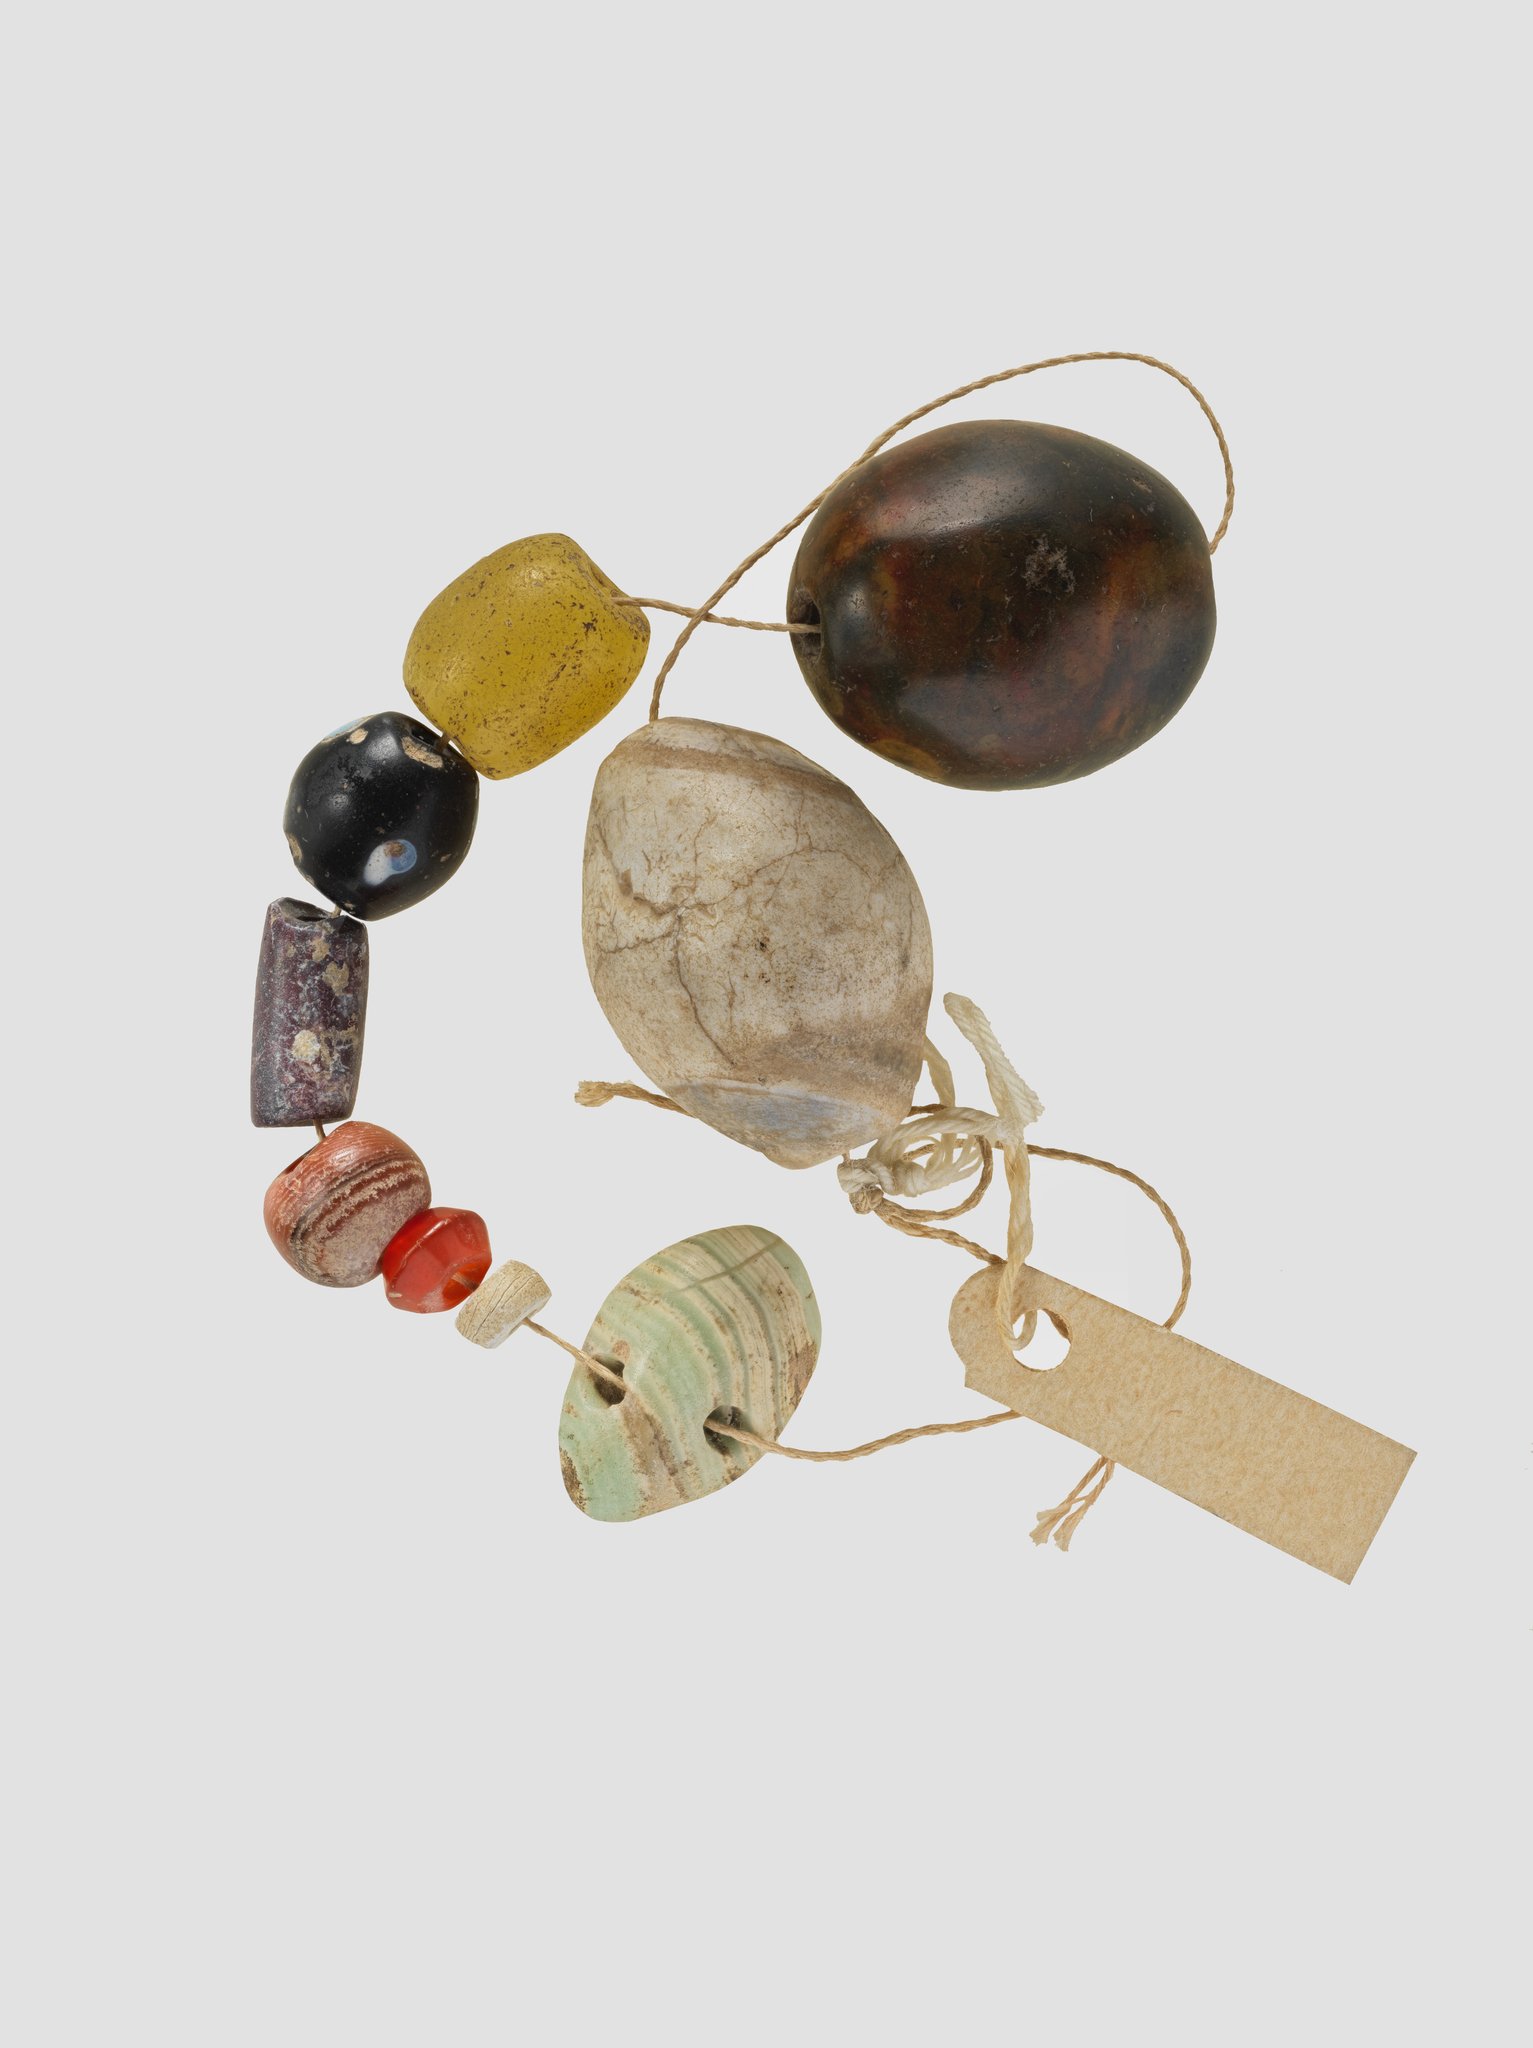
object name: bead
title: Beads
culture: iranian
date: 3000-2001 BCE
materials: stone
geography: iran